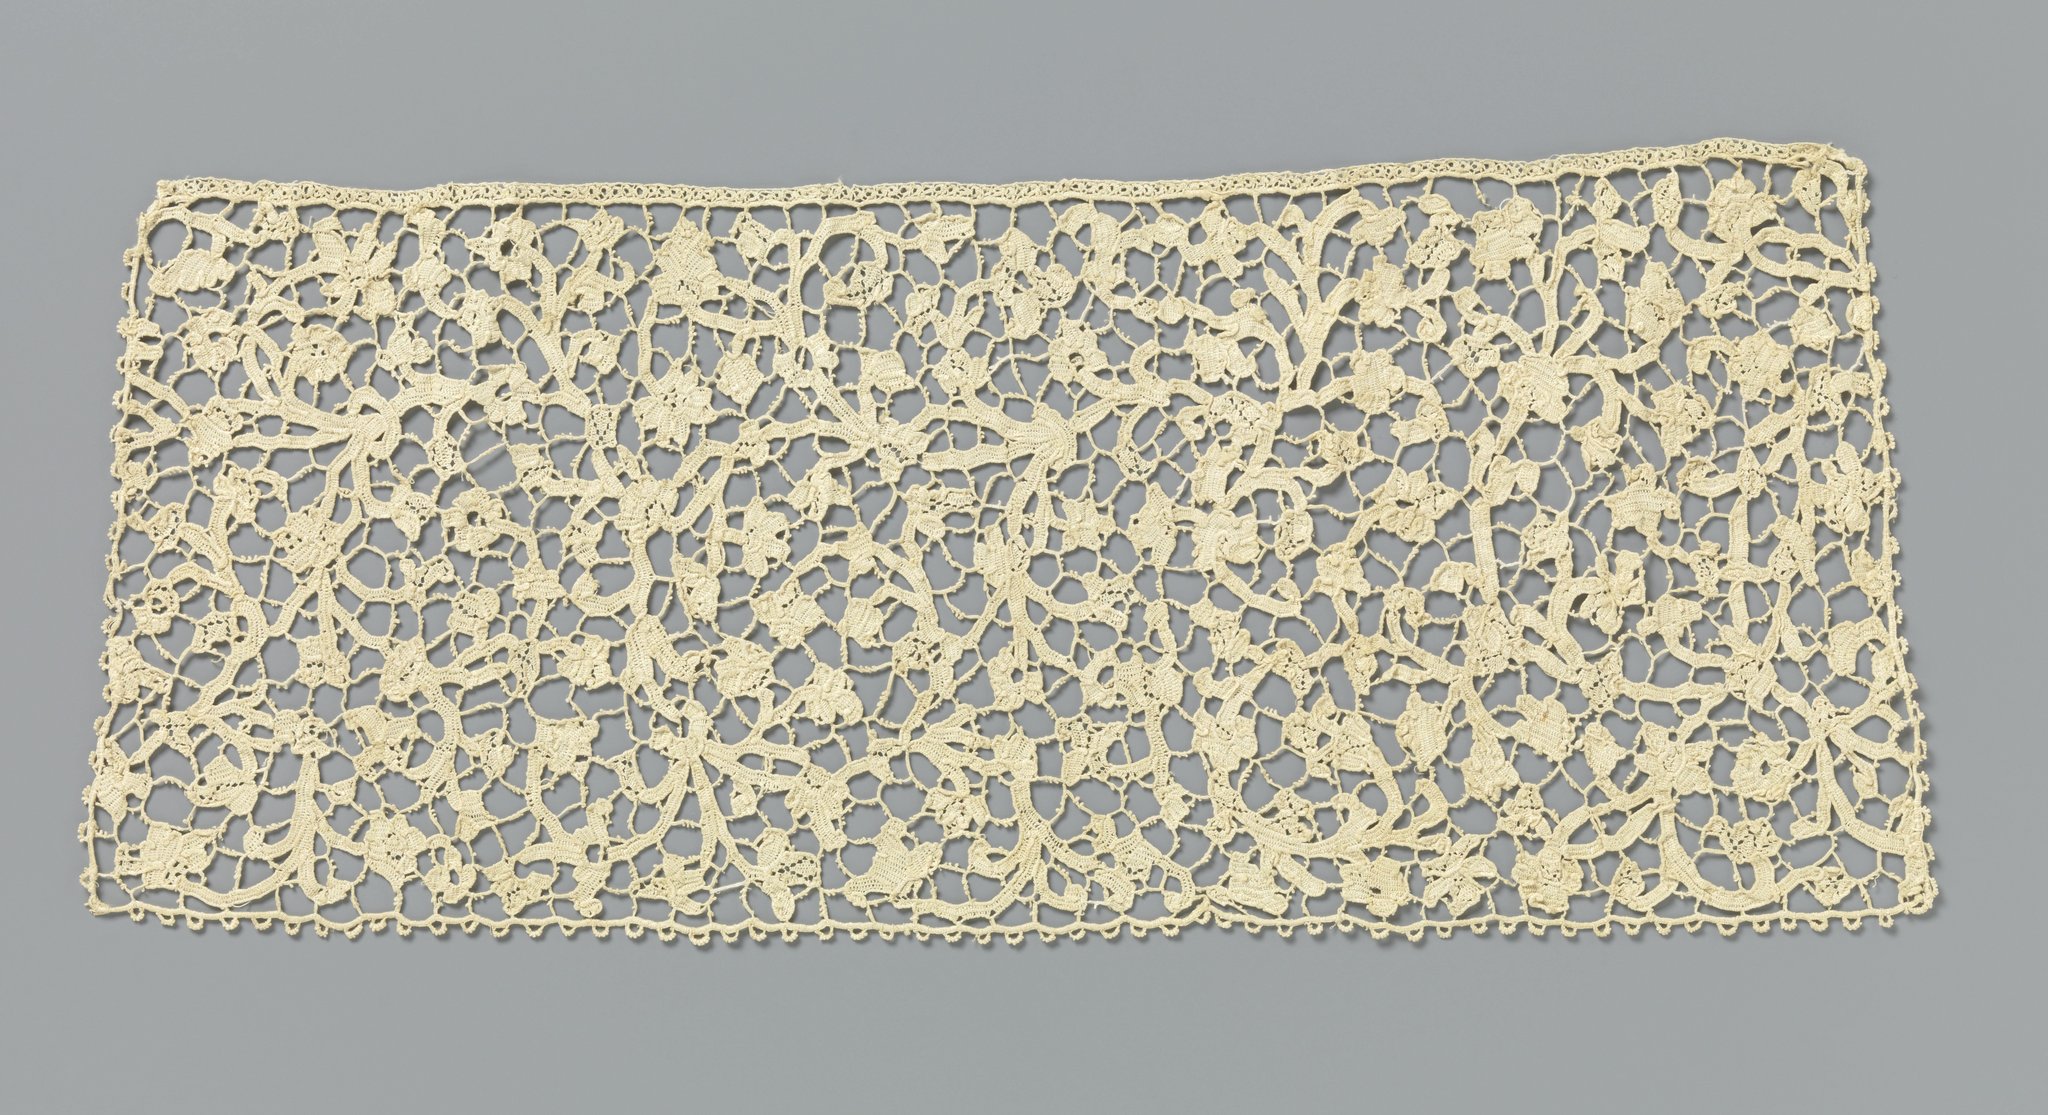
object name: clothing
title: Dasslip van naaldkant met symmetrisch patroon van vele ranken met kleine bladeren en bloemen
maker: Anonymous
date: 1675-1699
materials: linen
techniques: needlepoint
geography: venice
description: Dasslip van naturelkleurige naaldkant: platte Venetiaanse kant. Ogenschijnlijk warrig doch symmetrisch patroon met een vertikale as in het midden van waaruit zich vele omkrullende bloem- en bladranken bewegen. De motieven zijn gemaakt met festonsteken, waarbij met uitsparingen eenvoudige patroontjes in verschillende bloemen en bladeren zijn gerealiseerd. De motieven zijn met elkaar verbonden door een gepicoteerde spijlengrond. De bovenzijde van de strook is afgewerkt met een geklost bandje. De onderzijde en twee korte zijden zijn afgewerkt met een boogjesrandje.